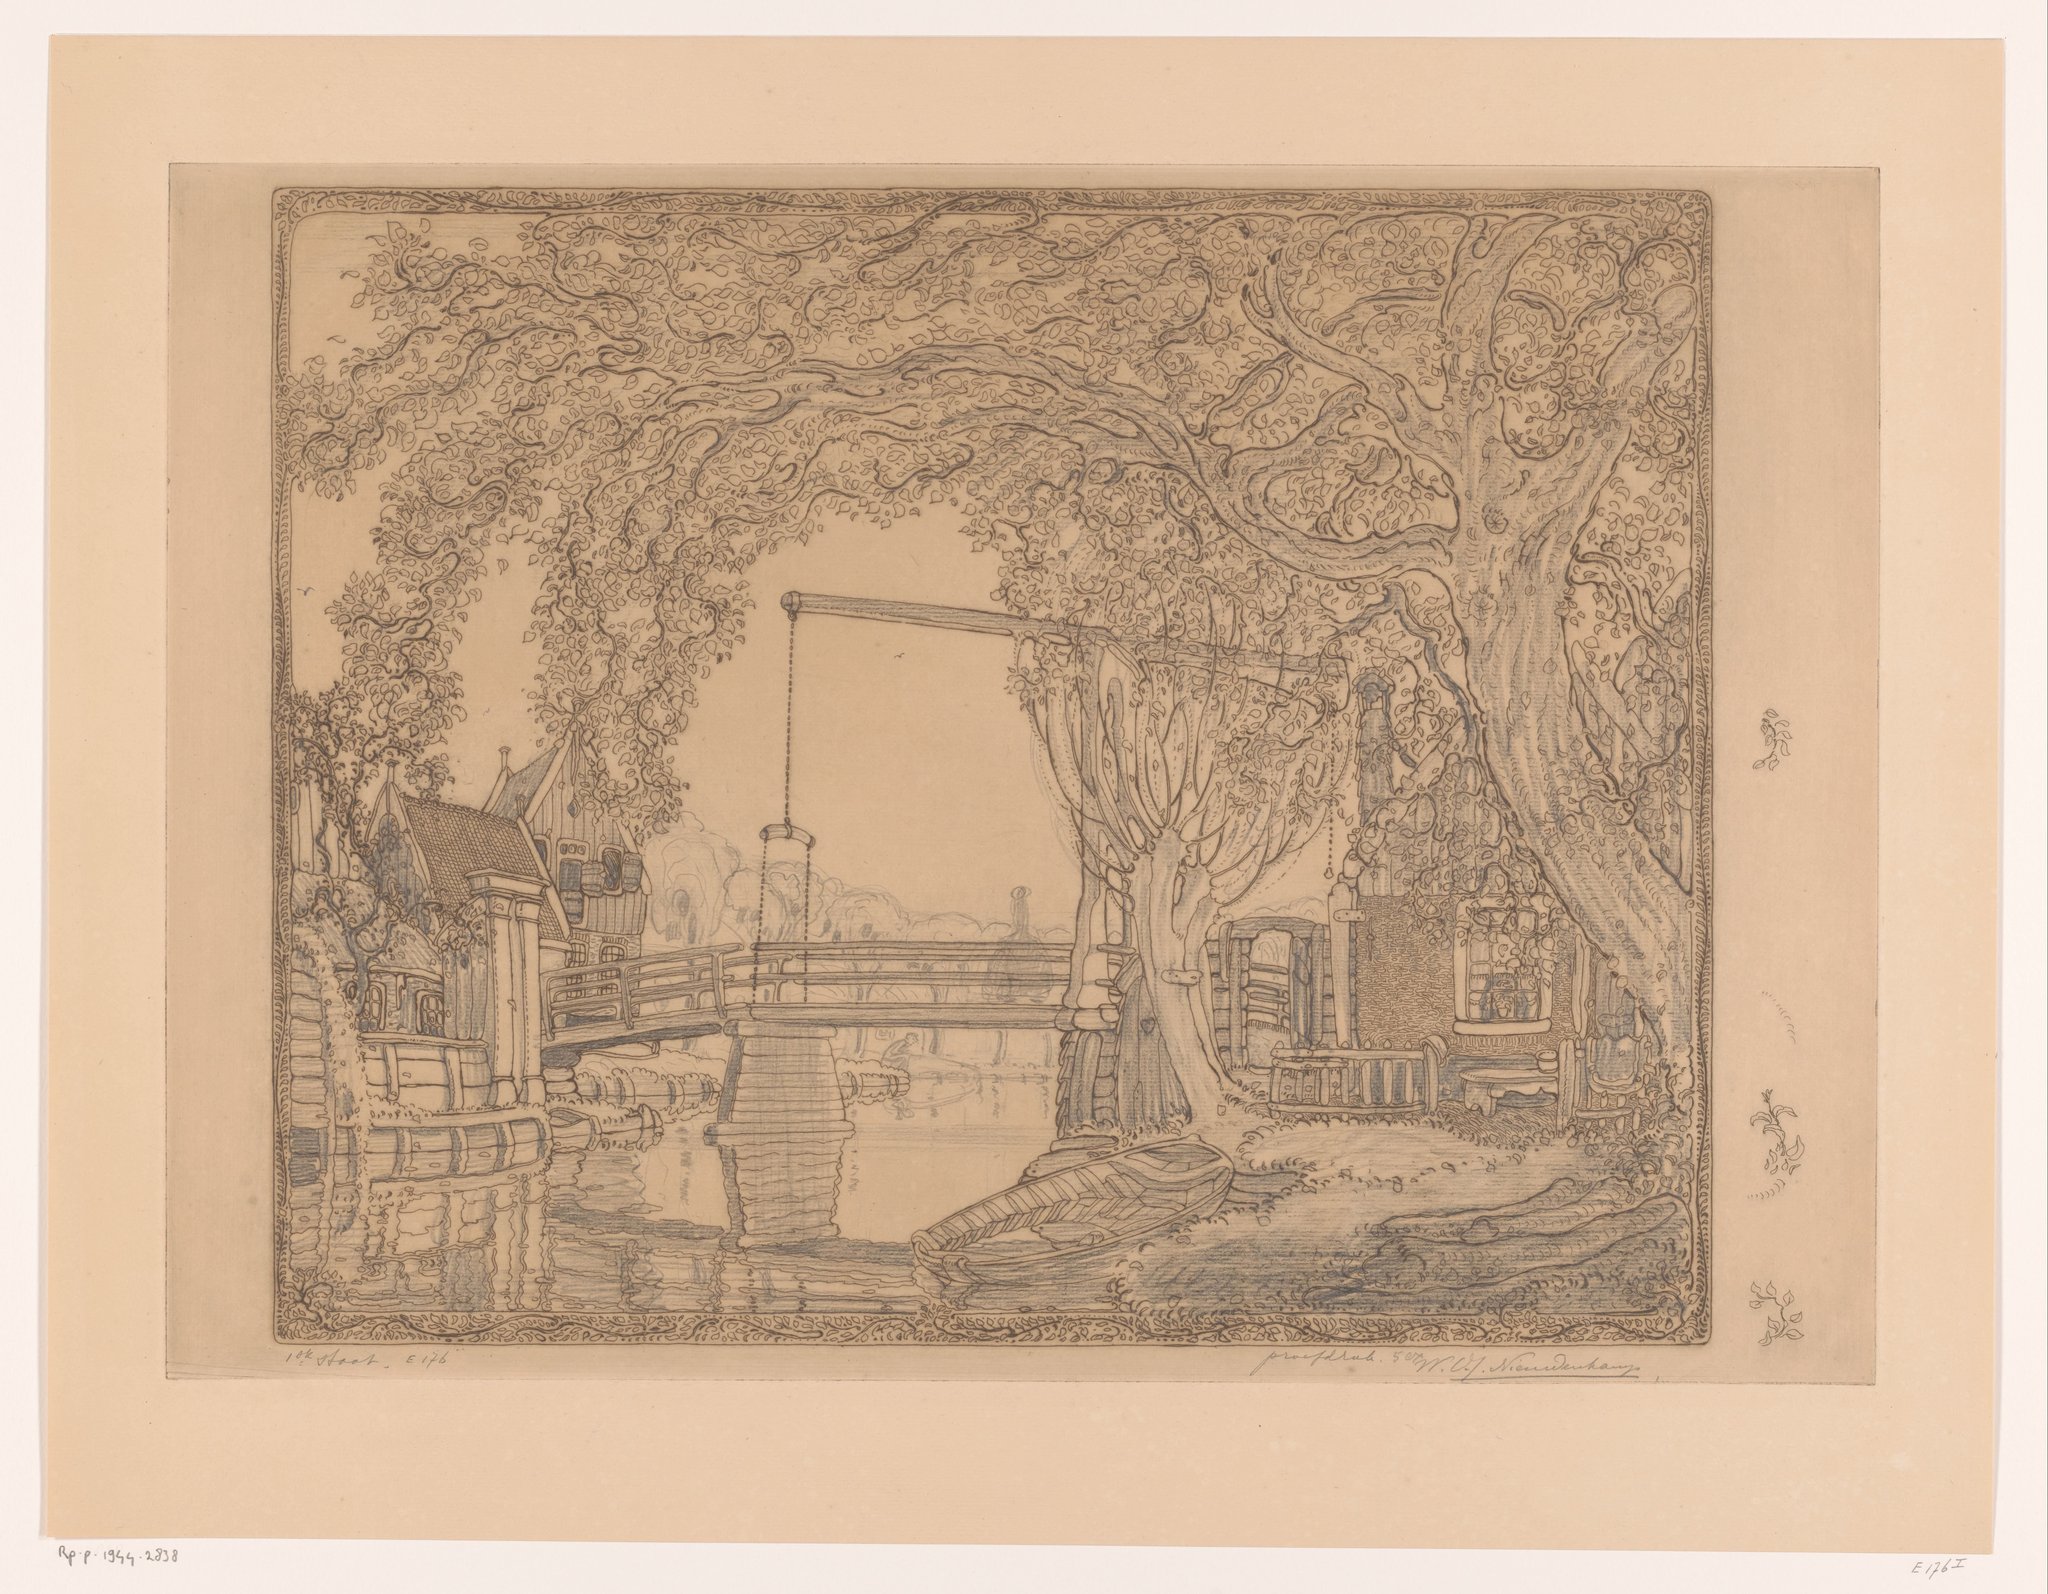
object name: print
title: De ophaalbrug Edam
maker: wijnand otto jan nieuwenkamp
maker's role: draughtsman, print maker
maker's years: 1874-1950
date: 1916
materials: paper, pencil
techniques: etching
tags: village, bridge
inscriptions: collector's mark: Lugt 2228